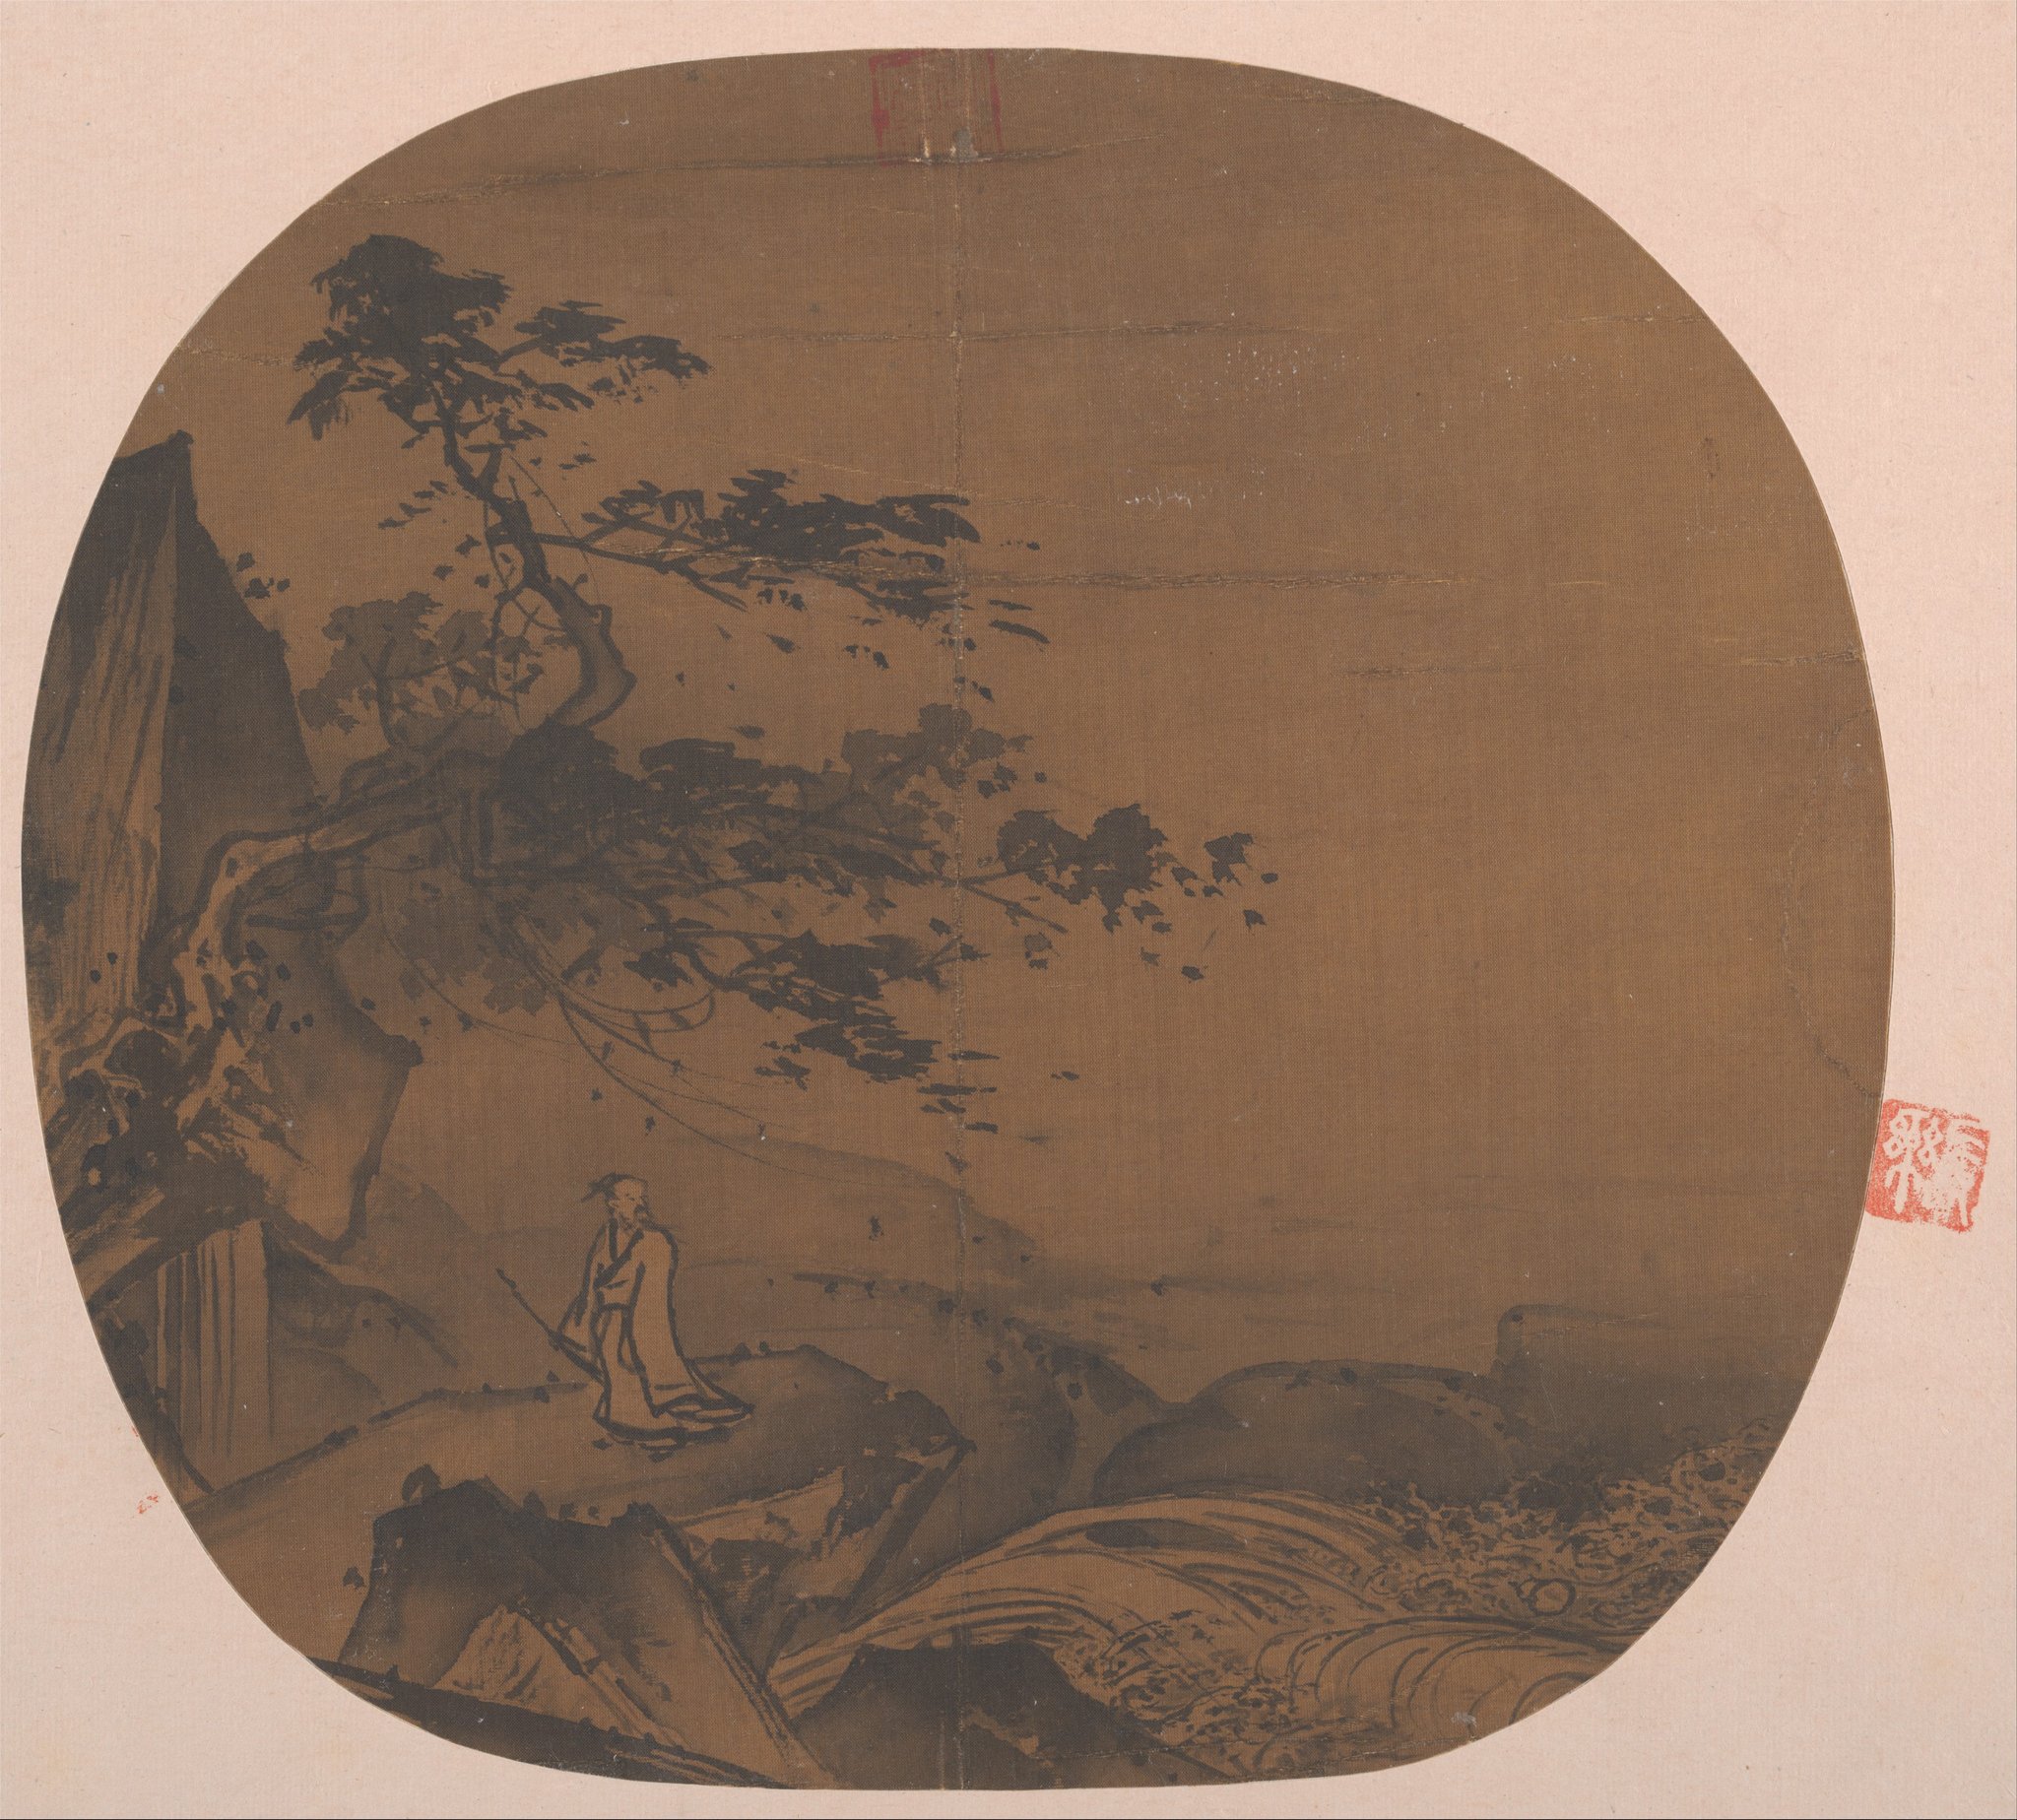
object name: fan mounted a an album leaf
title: Sage under Windy Tree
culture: chinese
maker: unidentified artist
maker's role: artist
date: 1701-1900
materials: ink, silk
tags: men,landscapes,trees